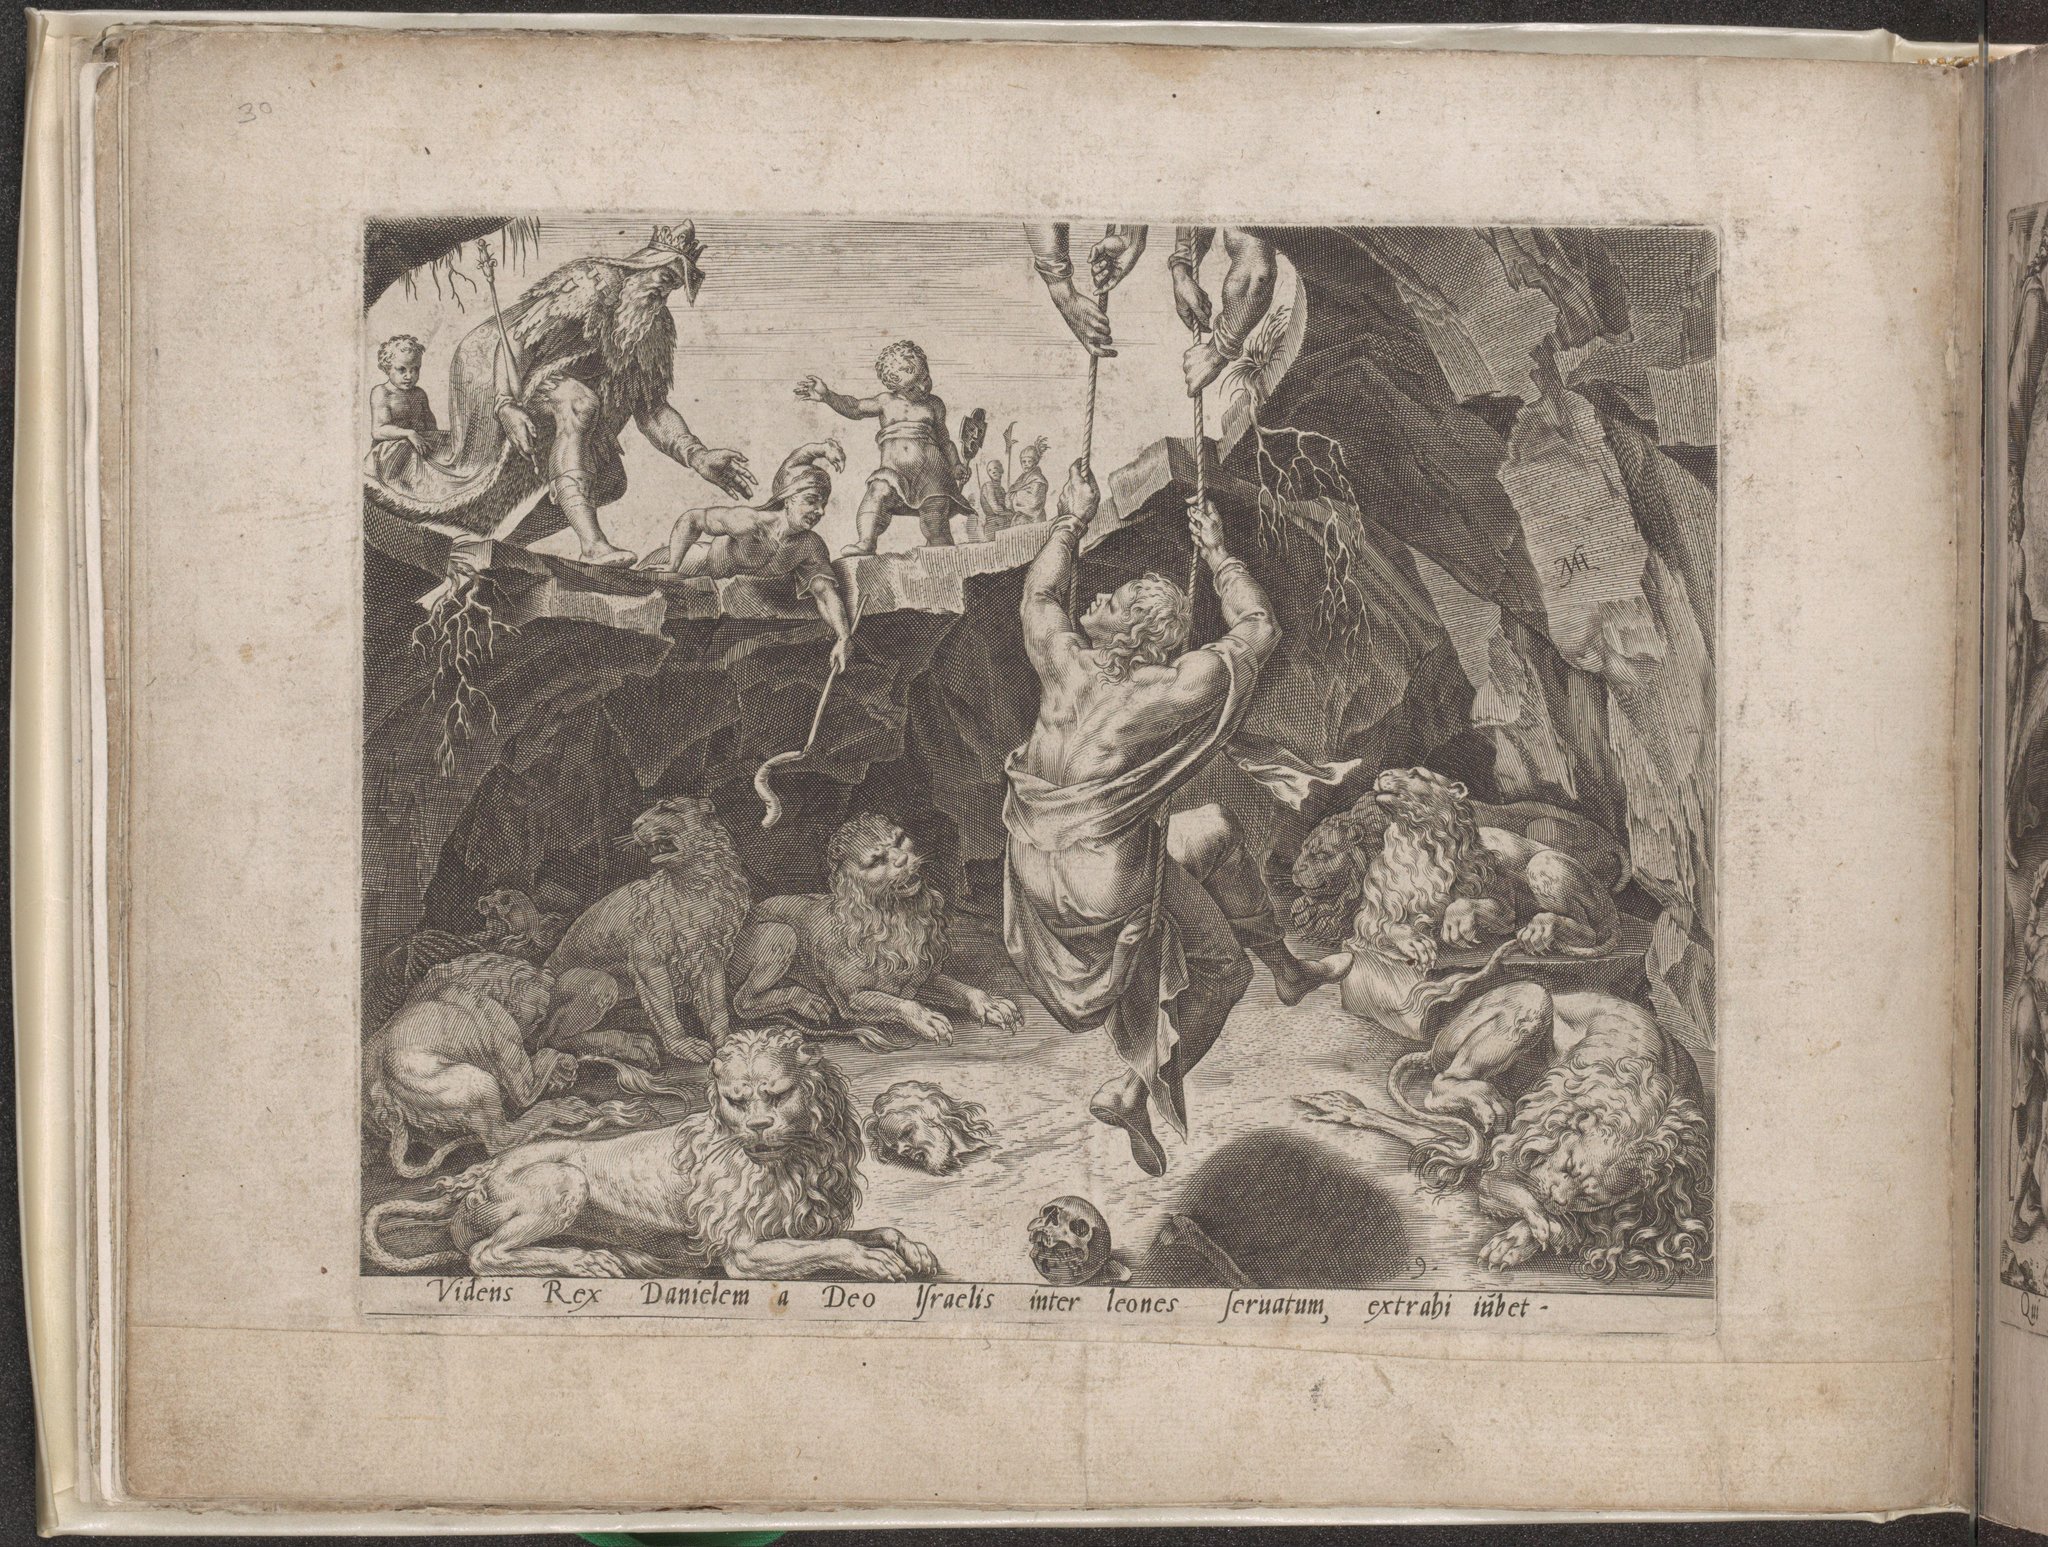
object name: album leaf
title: Geschiedenis van Daniël, Bel en de draak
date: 1565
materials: paper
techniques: engraving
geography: antwerp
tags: daniel is liberated from the lion's den ~ king cyrus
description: Koning Cyrus vindt Daniël na zeven dagen levend in de leeuwenkuil en laat hem met touwen omhoog halen. Onder de voorstelling een verklarende tekst in het Latijn. Deze prent maakt deel uit van een album.